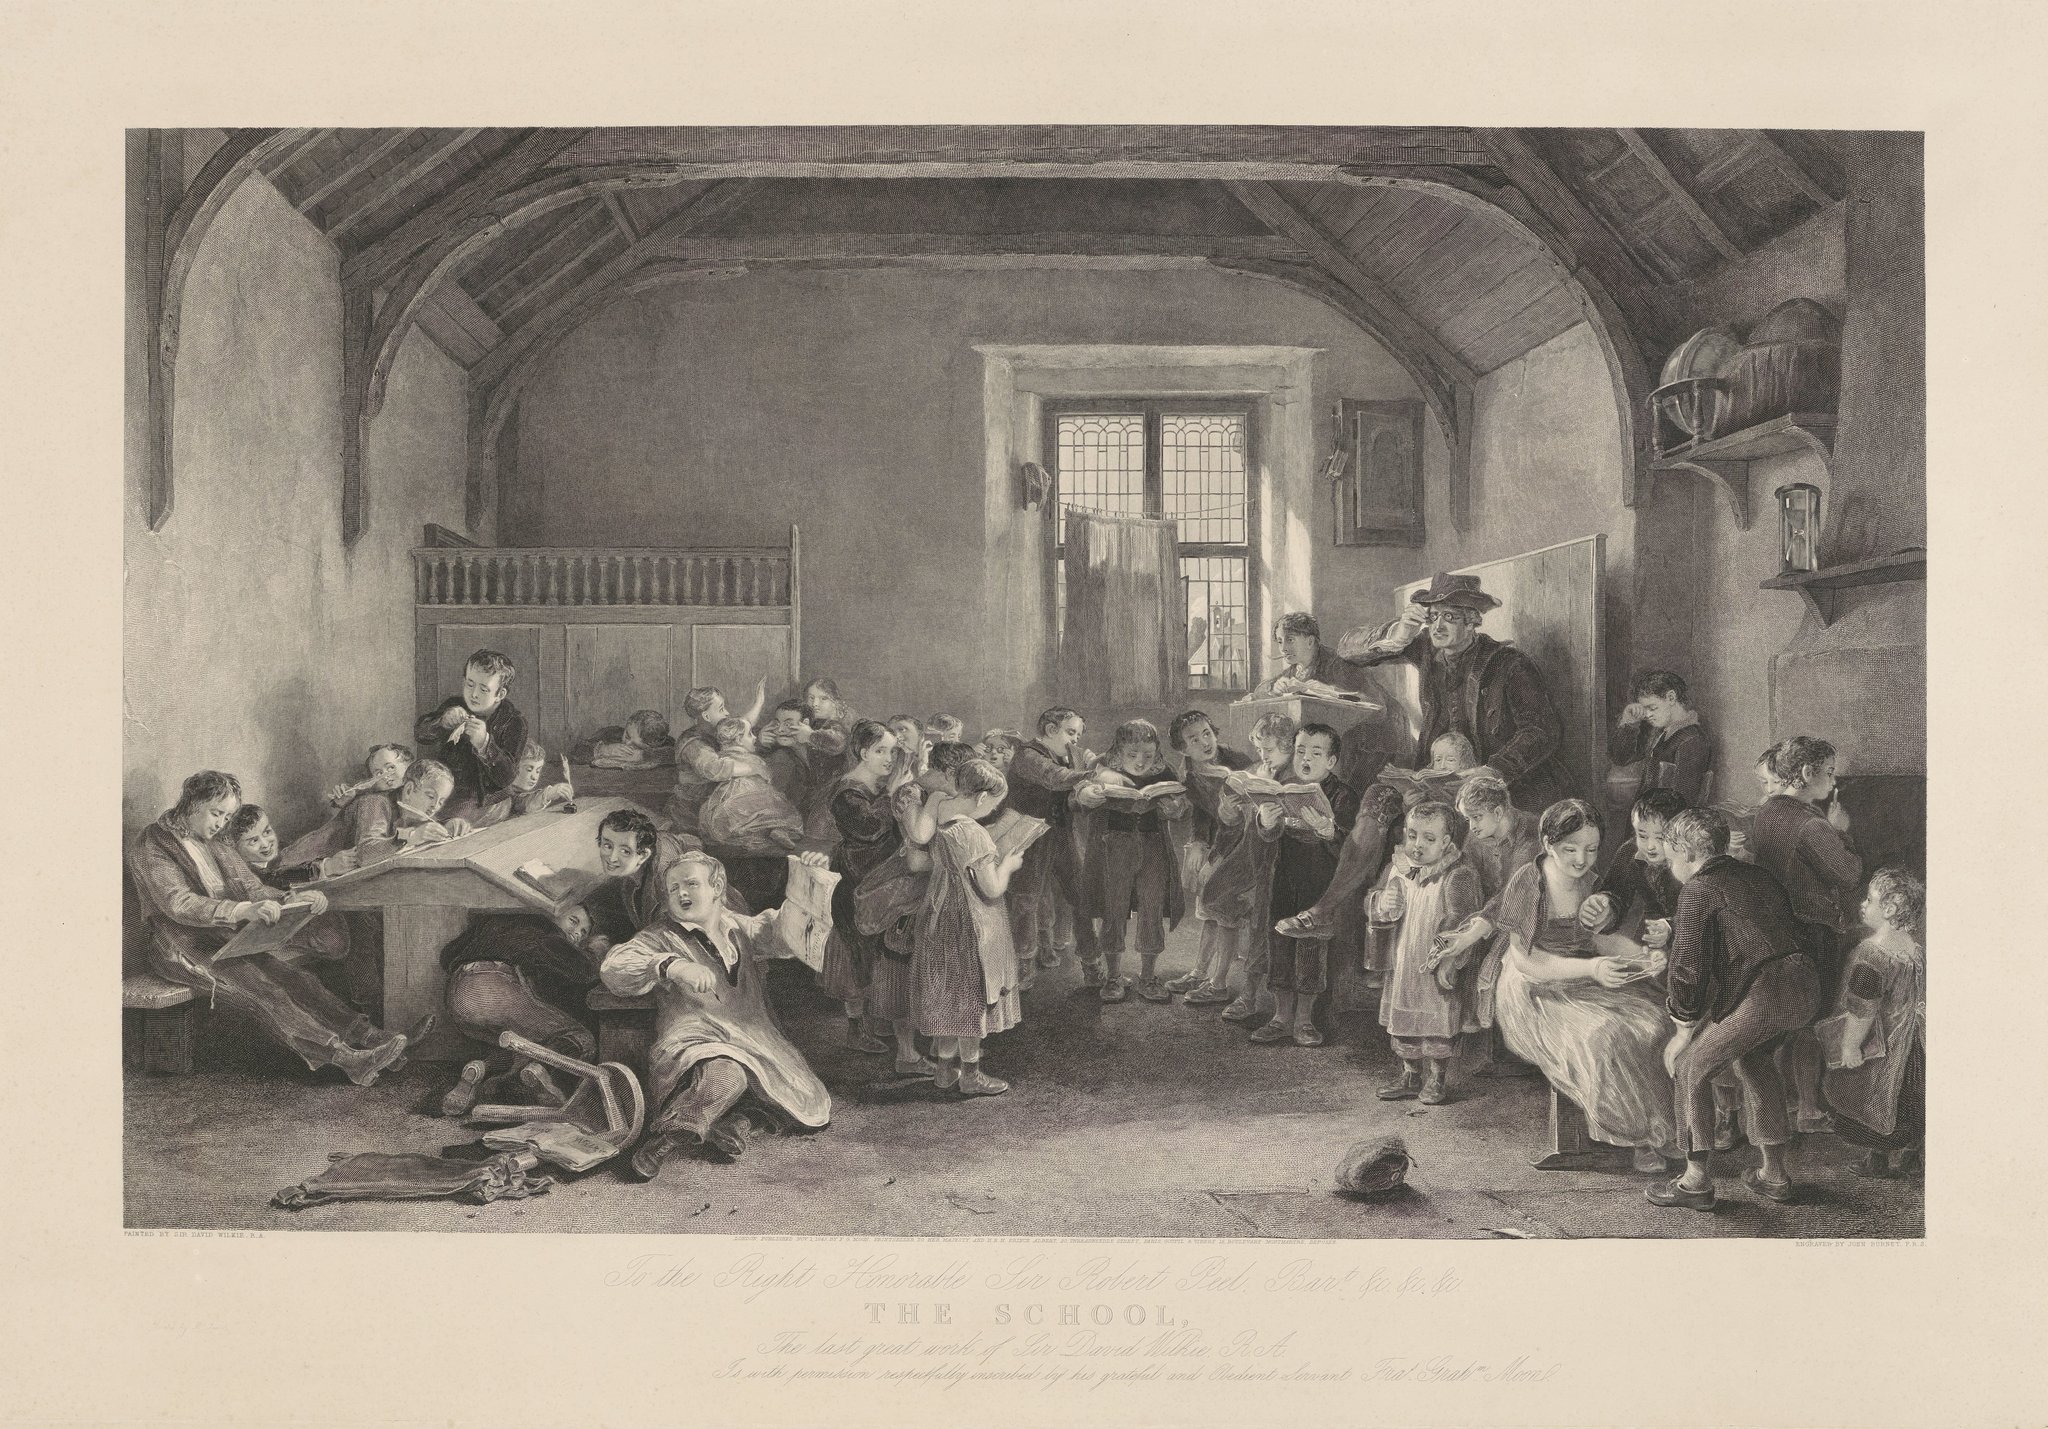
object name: print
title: The School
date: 1845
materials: paper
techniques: engraving, etching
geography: paris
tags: elementary school; class, form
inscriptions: collector's mark: Lugt 2228